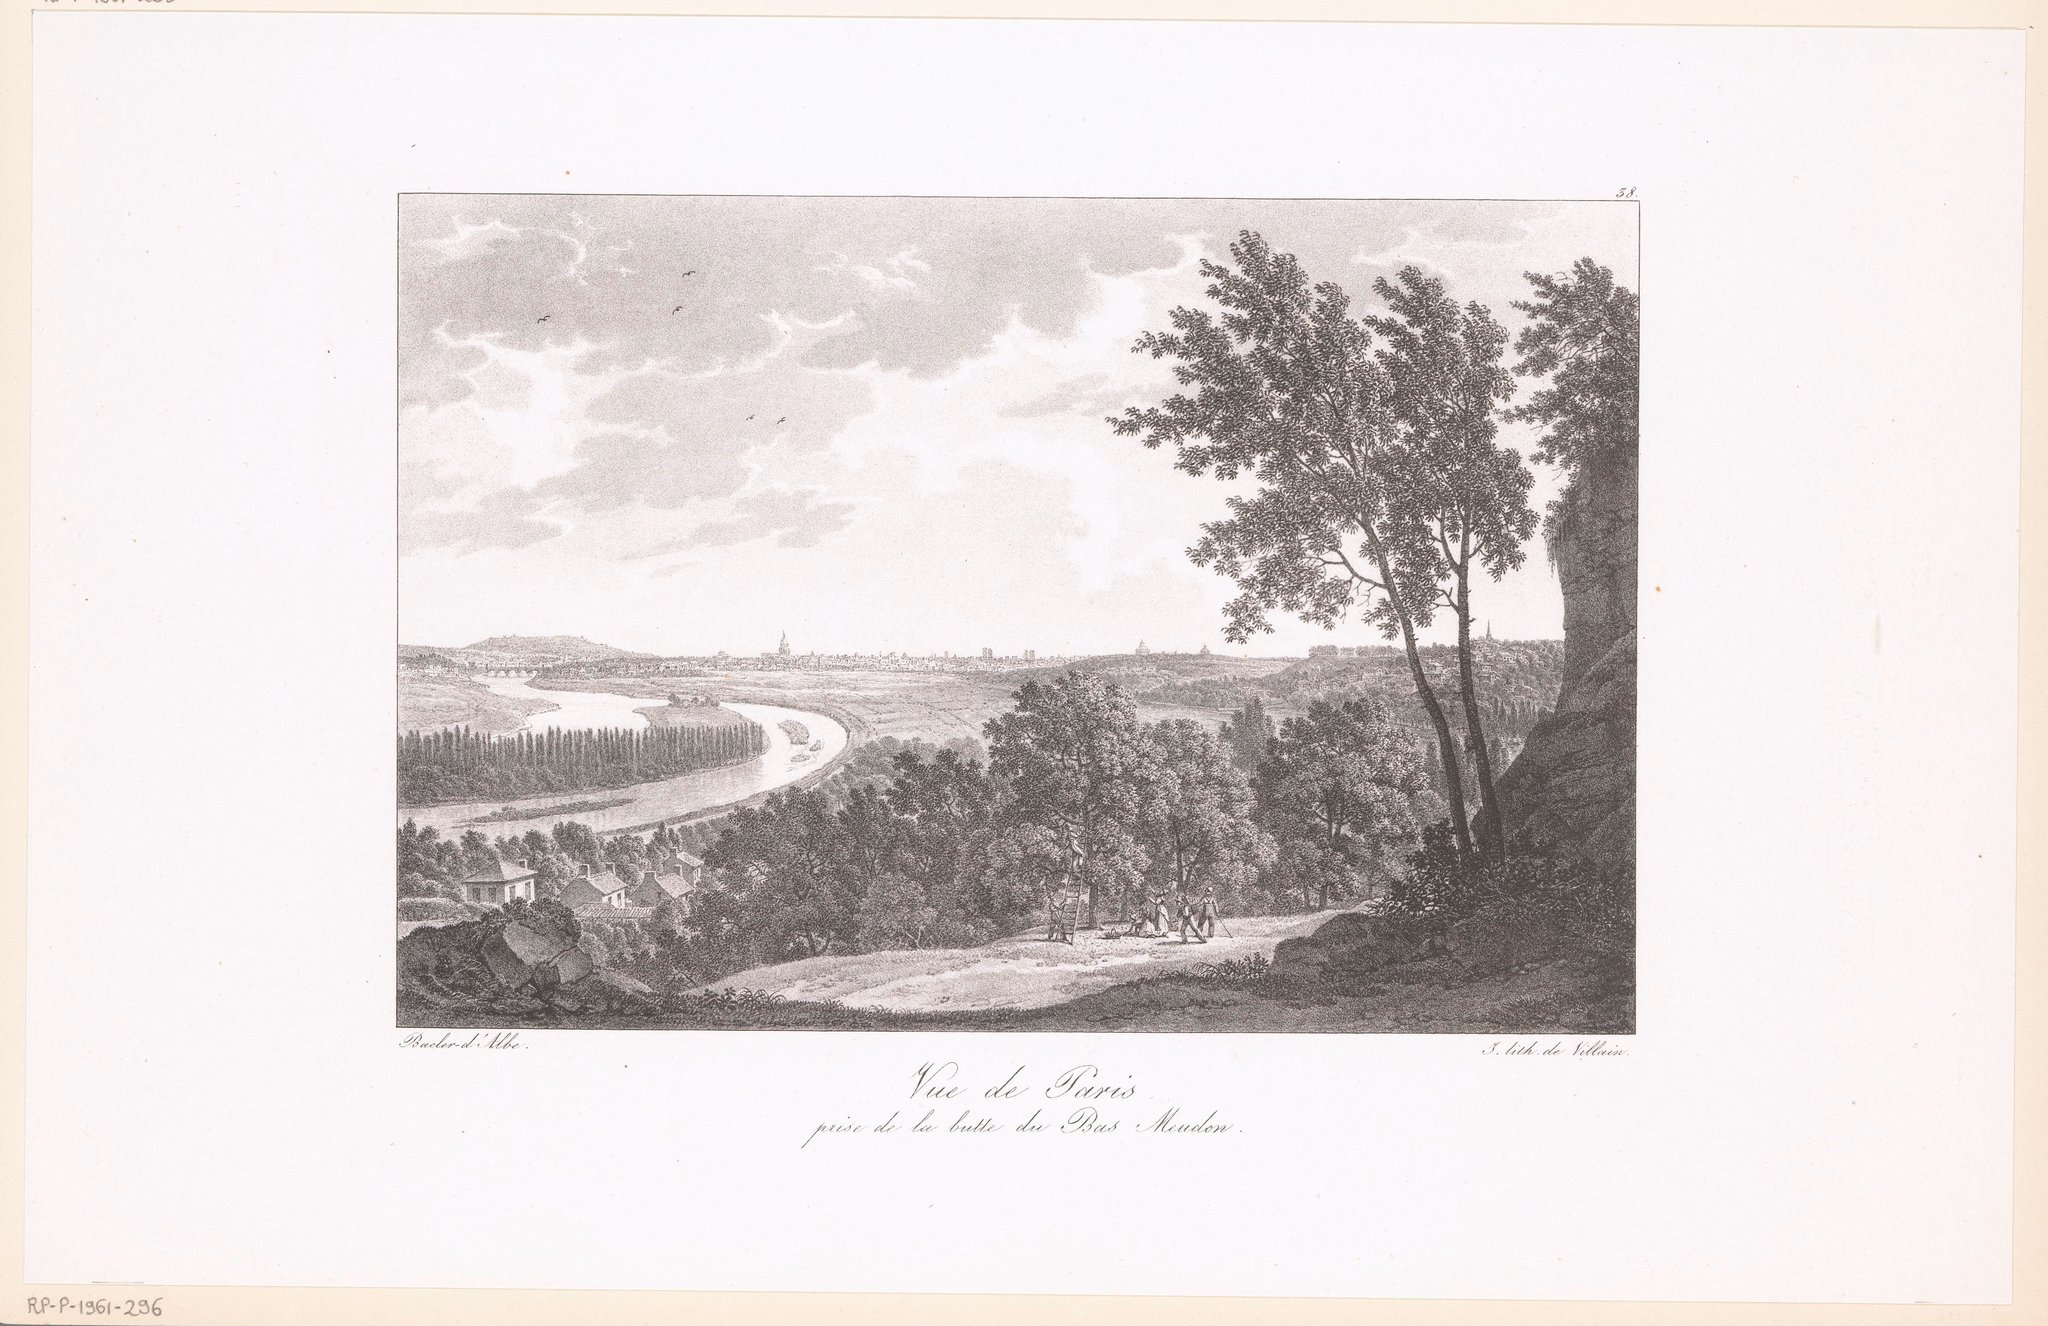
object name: print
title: Vue de Paris prise de la butte du Bas Meudon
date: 1822-1824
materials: paper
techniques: lithograph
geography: paris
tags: city-view in general; 'veduta', orchard, river (+ landscape with figures, staffage)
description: In de boomgaard in het midden van de prent zijn figuren aan het plukken.